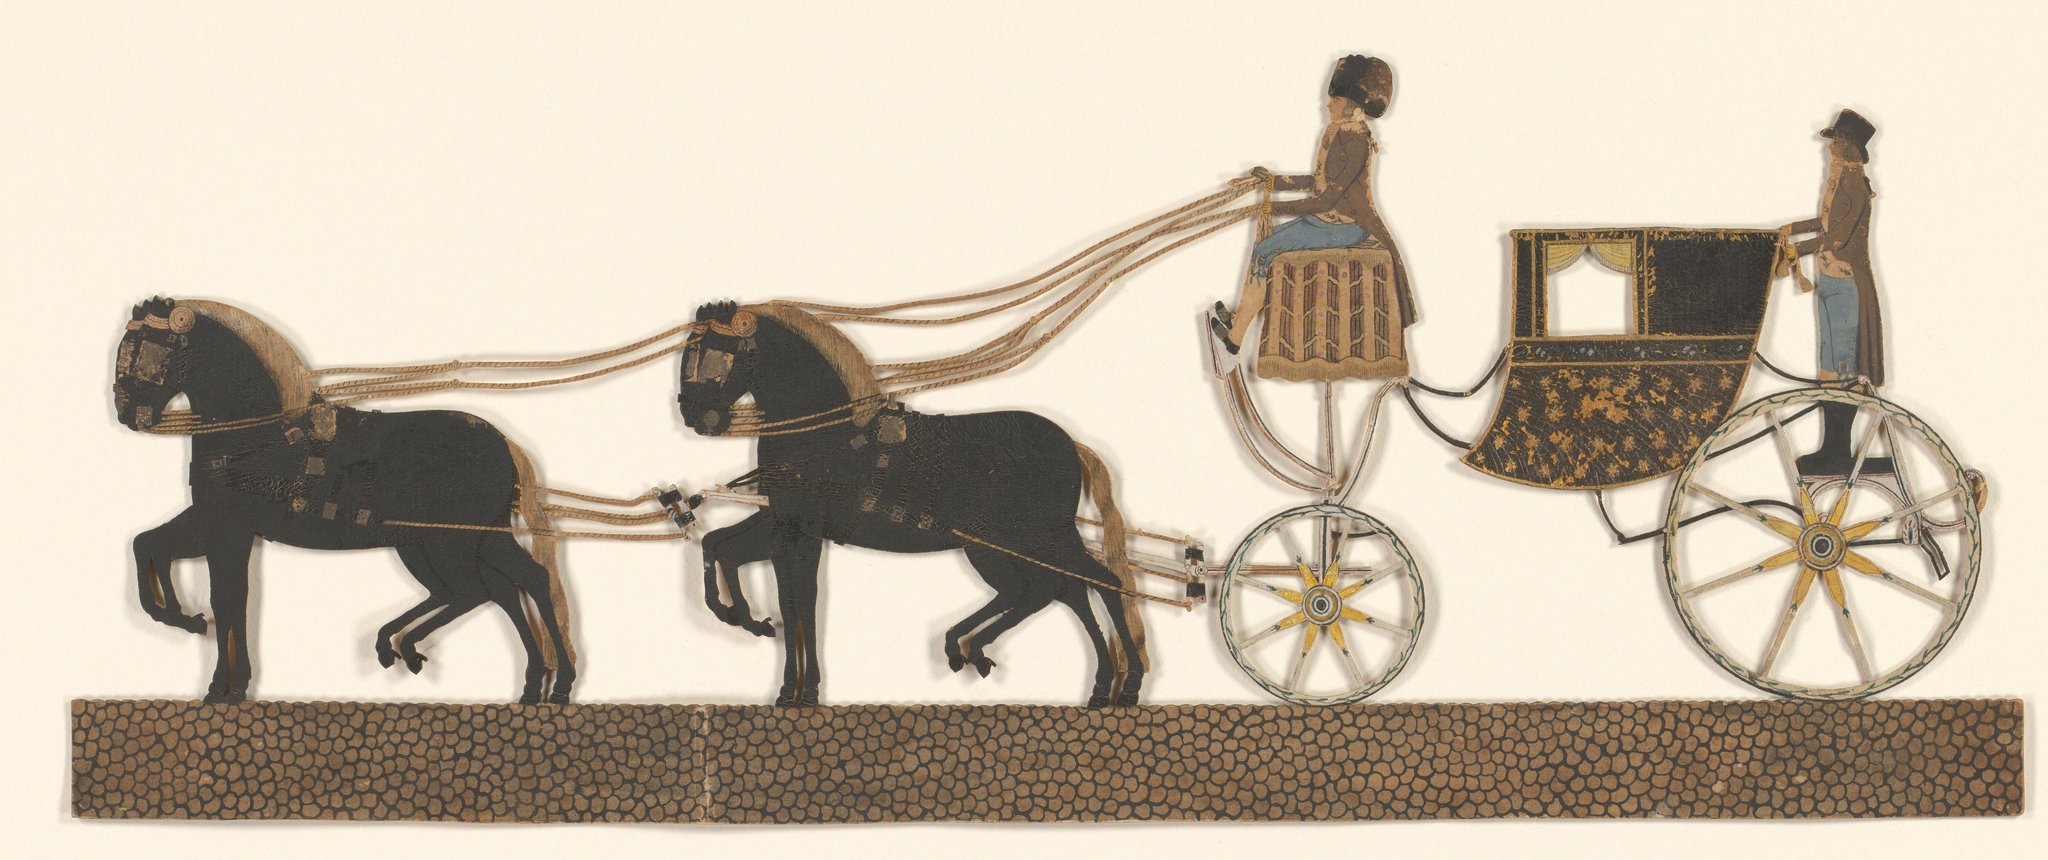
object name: clipping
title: Knipsel van rijtuig met koetsier en palfrenier, bespannen met vier paarden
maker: Anonymous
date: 1750-1850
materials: cardboard, paint, paper, watercolor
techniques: brush, pen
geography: netherlands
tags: four-wheeled vehicle drawn by more than three animals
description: Knipsel van een rijtuig met venster, met koetsier en palfrenier, bespannen met vier paarden. Knipsel van beschilderd karton.